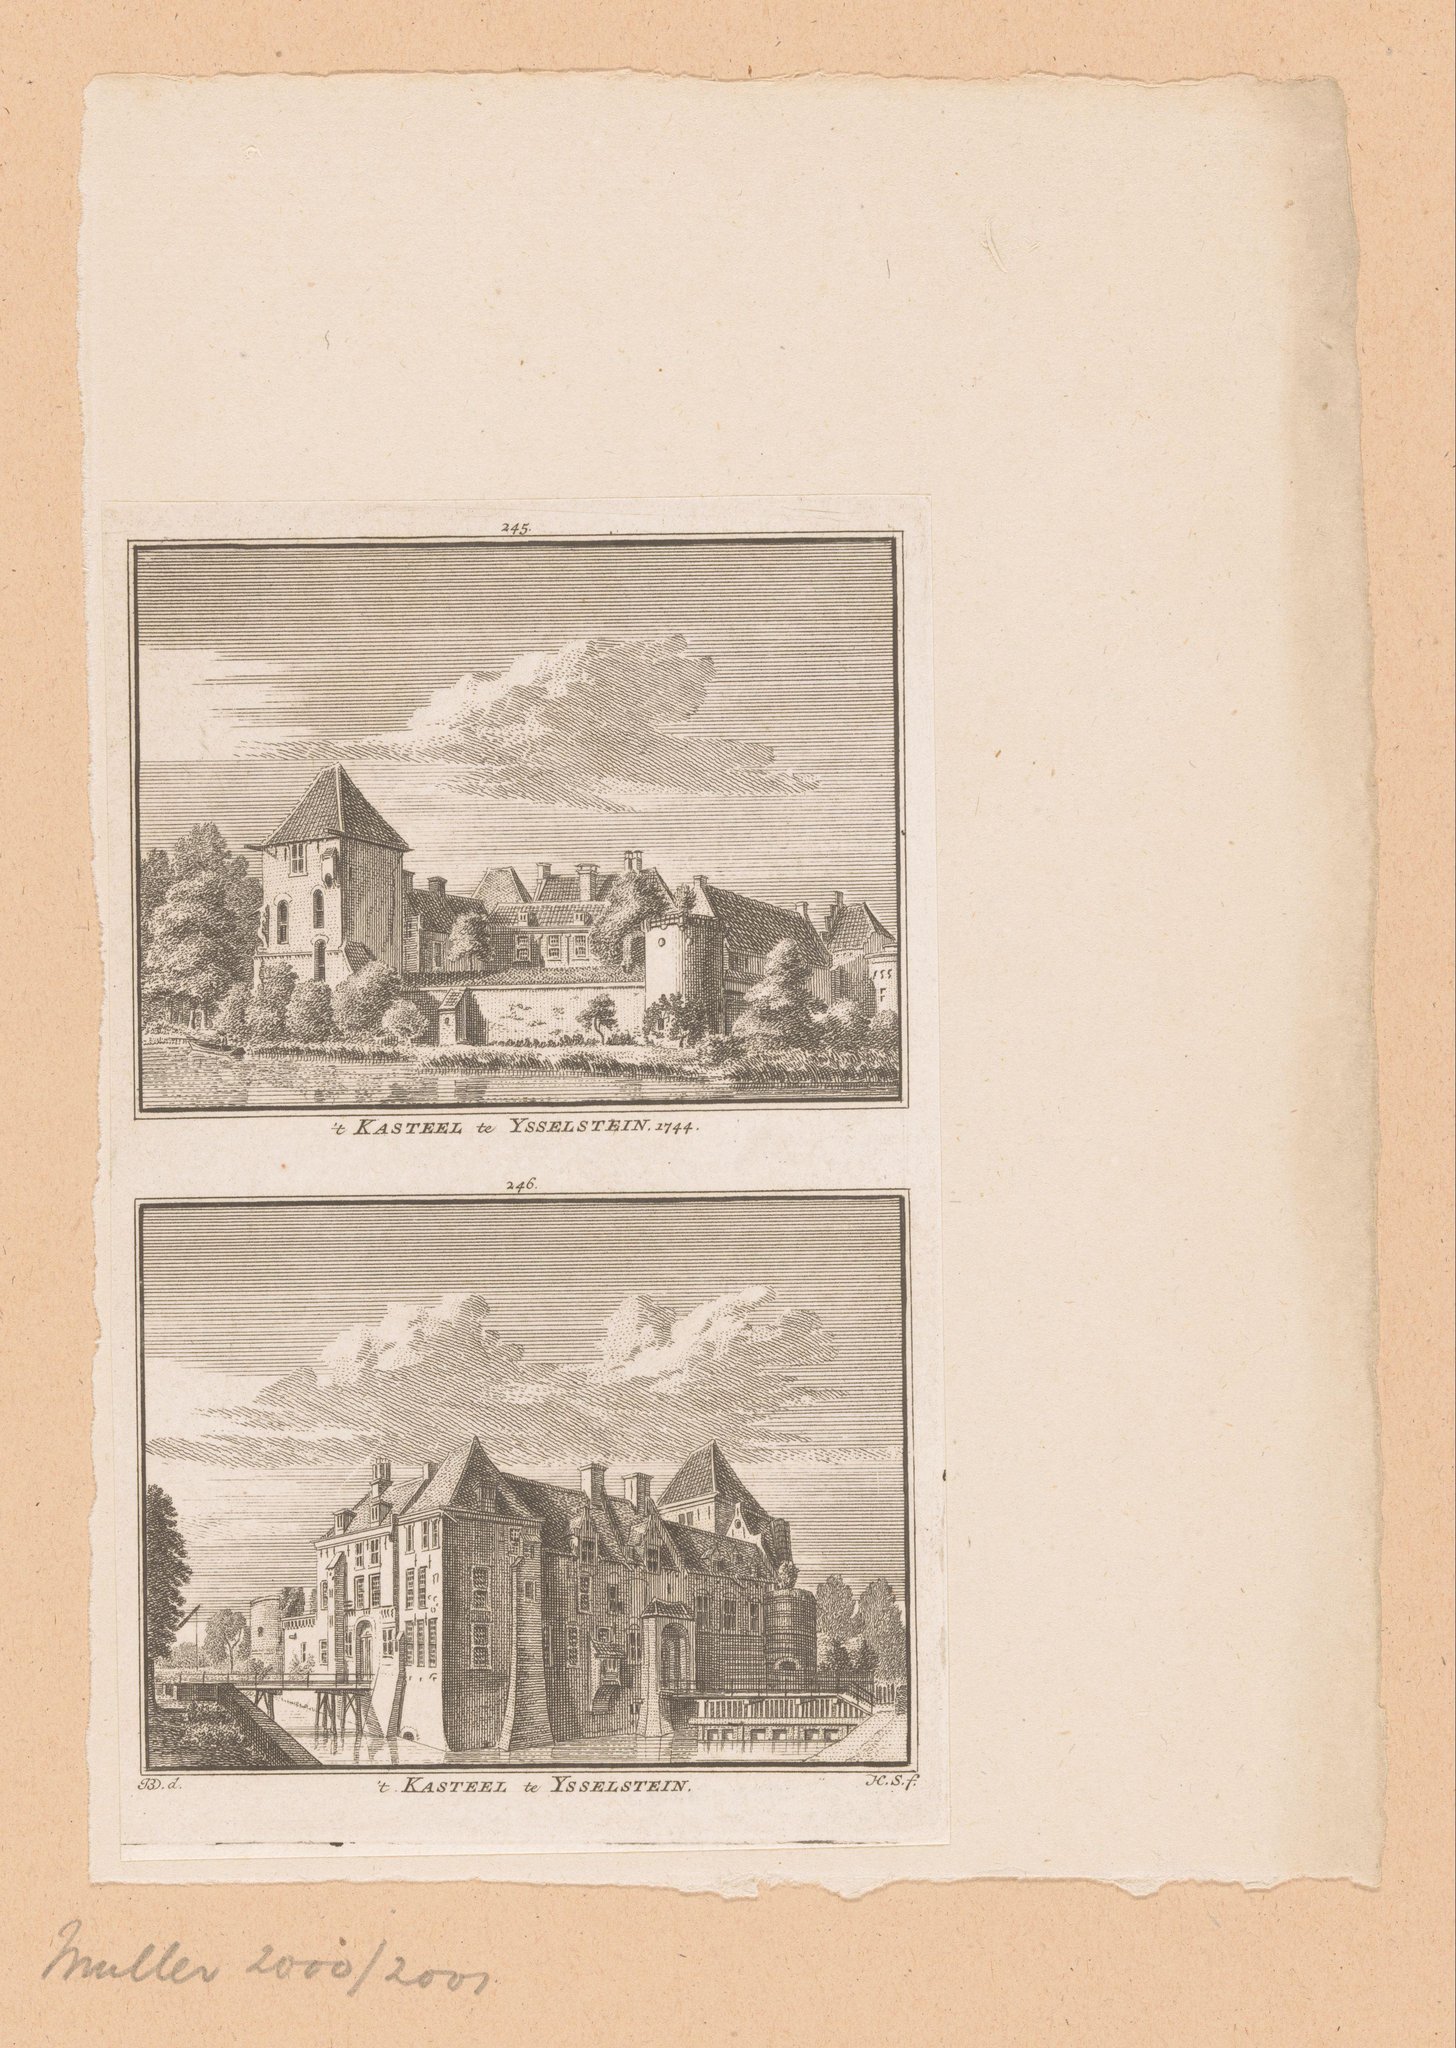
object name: book illustration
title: 't Kasteel te Ysselstein. 1744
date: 1745-1774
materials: paper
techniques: engraving, etching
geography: amsterdam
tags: castle, landscape with tower or castle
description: Prent uit: Spilman, Hendrik. Het verheerlykt Nederland; of, kabinet van hedendaagsche gezigten (...). 9 dln. Amsterdam: Isaak Tirion, 1745-1774.